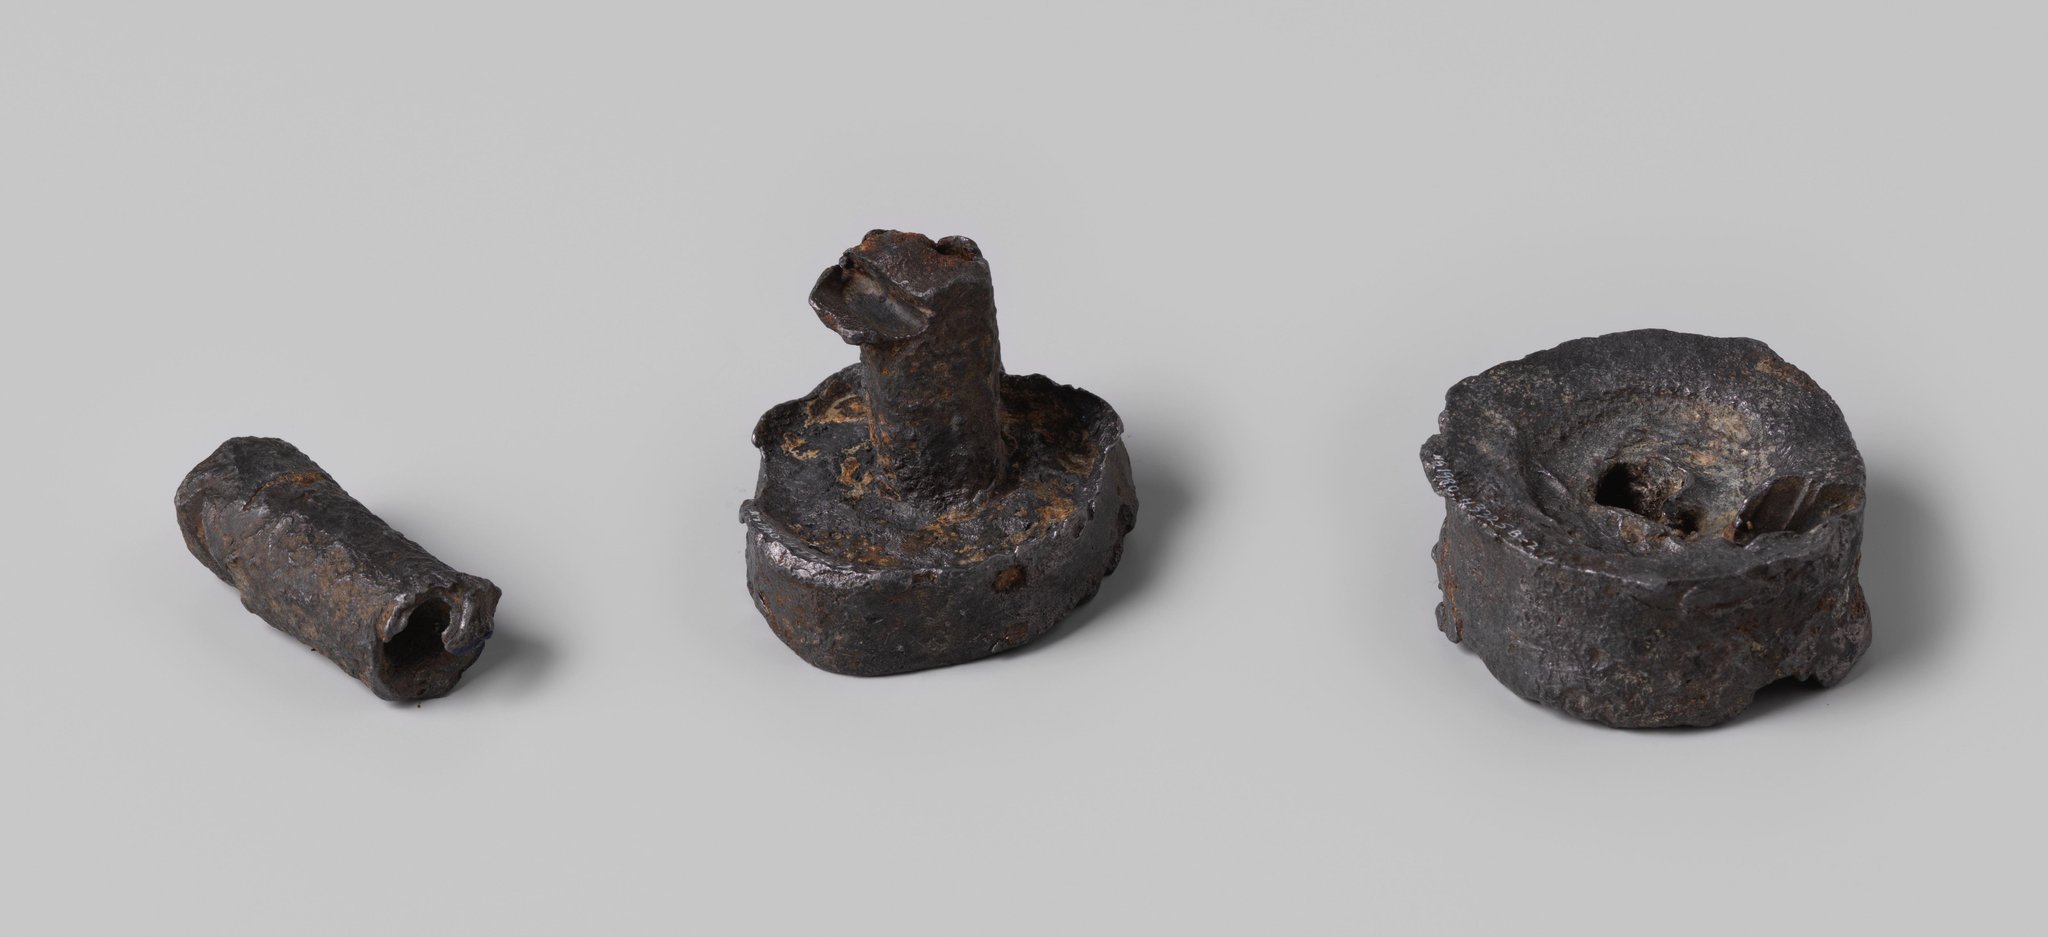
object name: weight scale component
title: Two lead weights from the wreck of the Dutch East India ship Hollandia with the coat of arms of Amsterdam and the year 1743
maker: Anonymous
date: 1700-1743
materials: lead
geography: netherlands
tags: verenigde oostindische compagnie, hollandia (schip), annet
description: Ring-handle weight, top: circular disc, flat underneath with round hollow shaft, flat top with 2 holes for handle, 3 inscriptions (III), coat of arms of Amsterdam on either side, 1743]: fragm, circular disc, concave underneath, shaft missing, flat top with 2 holes for handle, 3 inscriptions (VI), coat of arms of Amsterdam on either side, 1743: fragm, round hollow shaft.